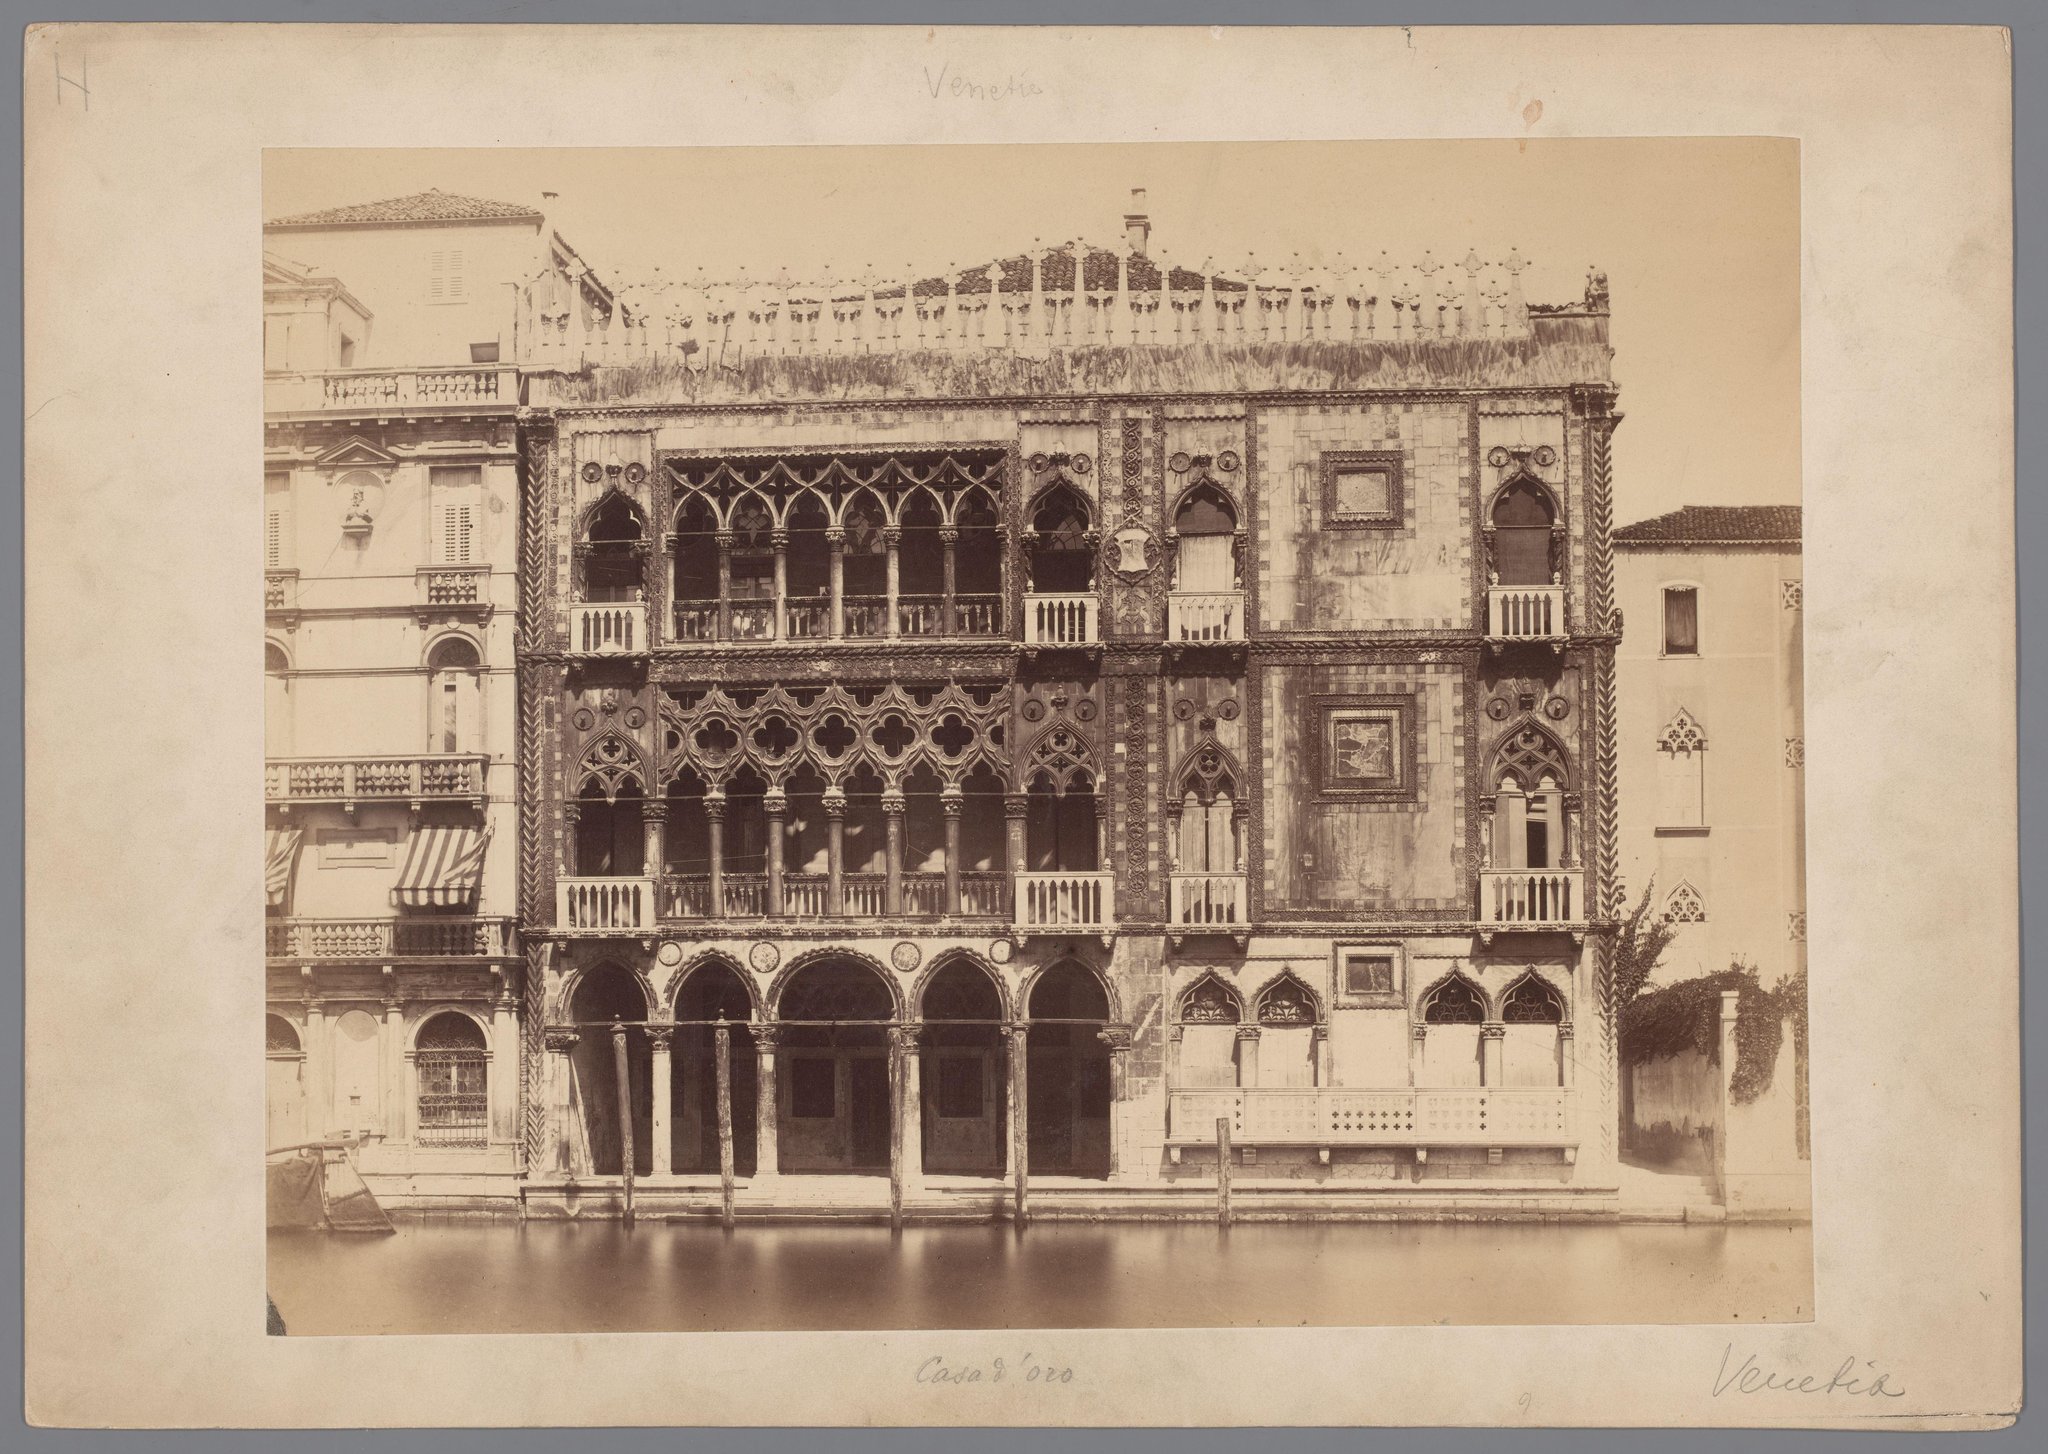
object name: photograph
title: Façade van het Ca' d'Oro te Venetië, Italië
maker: carlo ponti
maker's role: fotograaf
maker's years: 1820-1893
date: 1852-1893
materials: cardboard, paper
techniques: albumen print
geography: venice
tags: canal, palace, venice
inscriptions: collector's mark: ‘RIJKS SCHOOL VOOR KUNSTNIJVERHEID/ GROEP’, inscription: ‘Venetie’, inscription: ‘Ponti (t)’, inscription: ‘Stijlk pl 8’, inscription: ‘Casa d'oro’, number: ‘I’